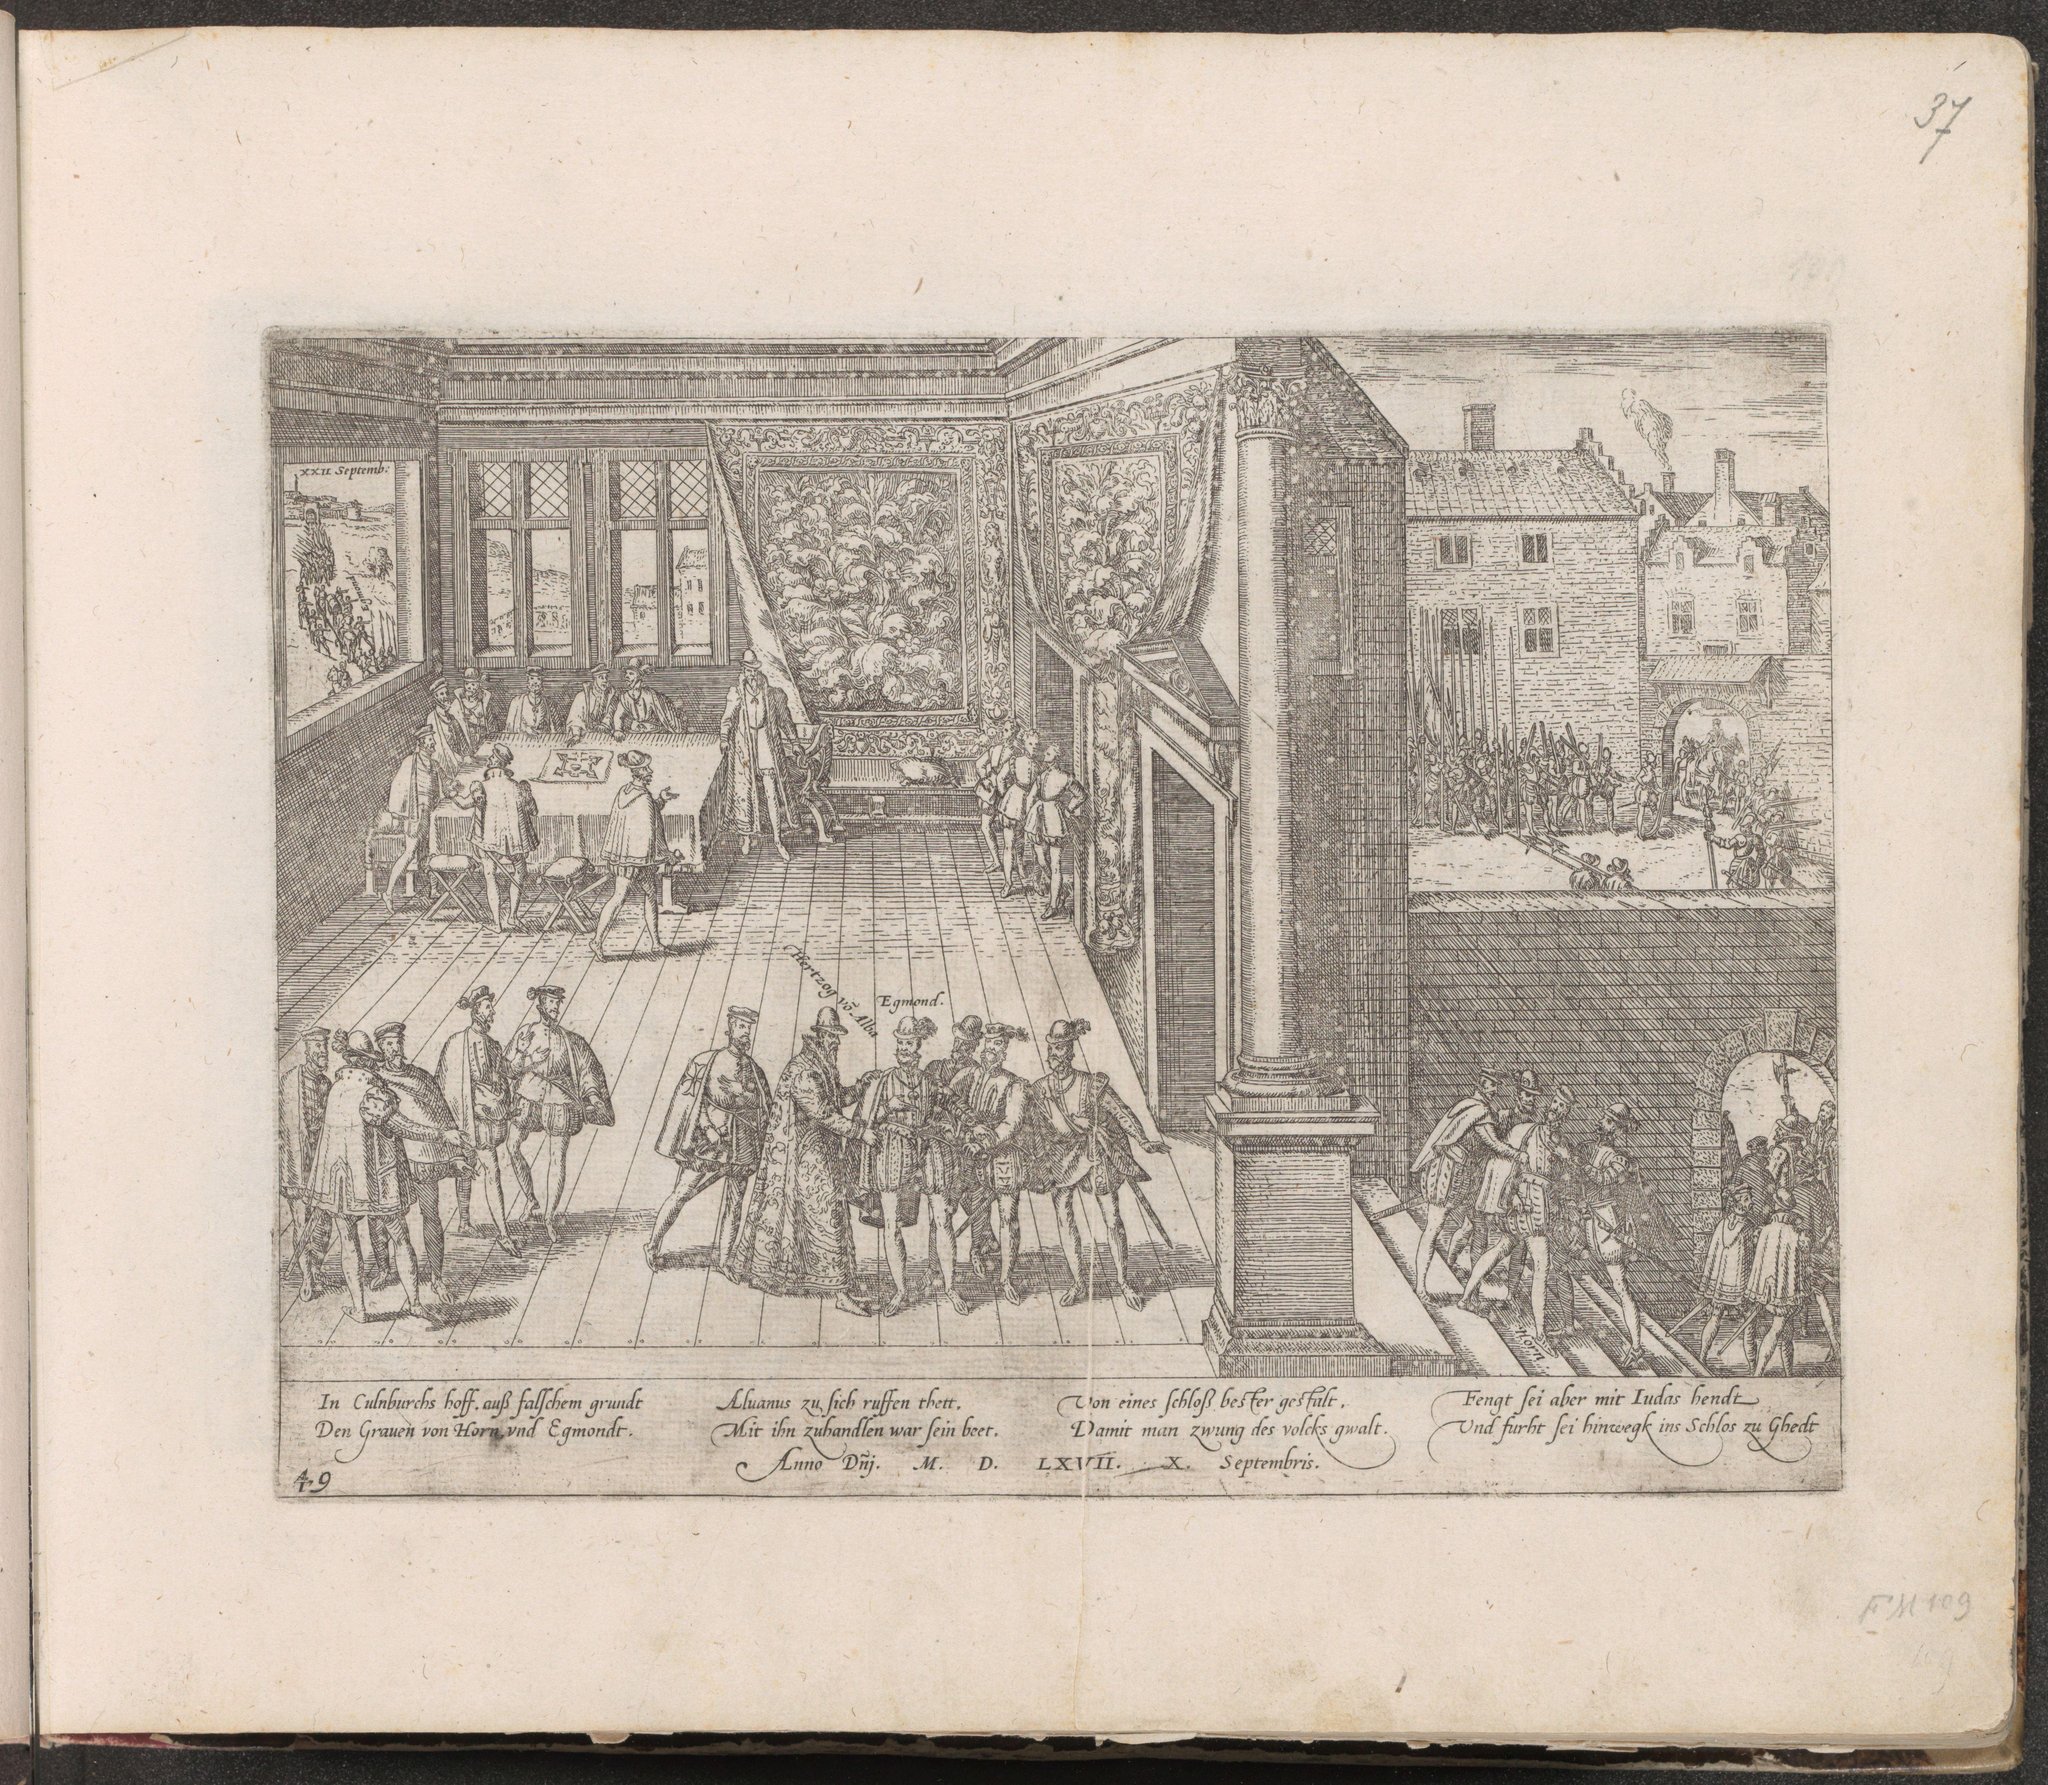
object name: album leaf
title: Serie 5: Nederlandse Gebeurtenissen, 1566-1570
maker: frans hogenberg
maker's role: print maker, publisher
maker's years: 1538-1590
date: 1568-1572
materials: paper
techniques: etching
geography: cologne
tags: fernando álvarez de toledo (3rd duke of alba), earl, law and jurisprudence (+ arrest), brussels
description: Gevangenneming van de graven van Egmond en Horne door Alva in het Hof van Culemborg aan de Zavel te Brussel, 10 september 1567. Gezicht in de zaal waar op de voorgrond Alva in een lange mantel de hand legt op de schouder van Egmond, rechts wordt Horne afgevoerd. Op de achtergrond staat Alva op van besprekingen aan een tafel. Met onderschrift van 8 regels in het Duits. Linksonder genummerd: 49. De prent maakt deel uit van een album.